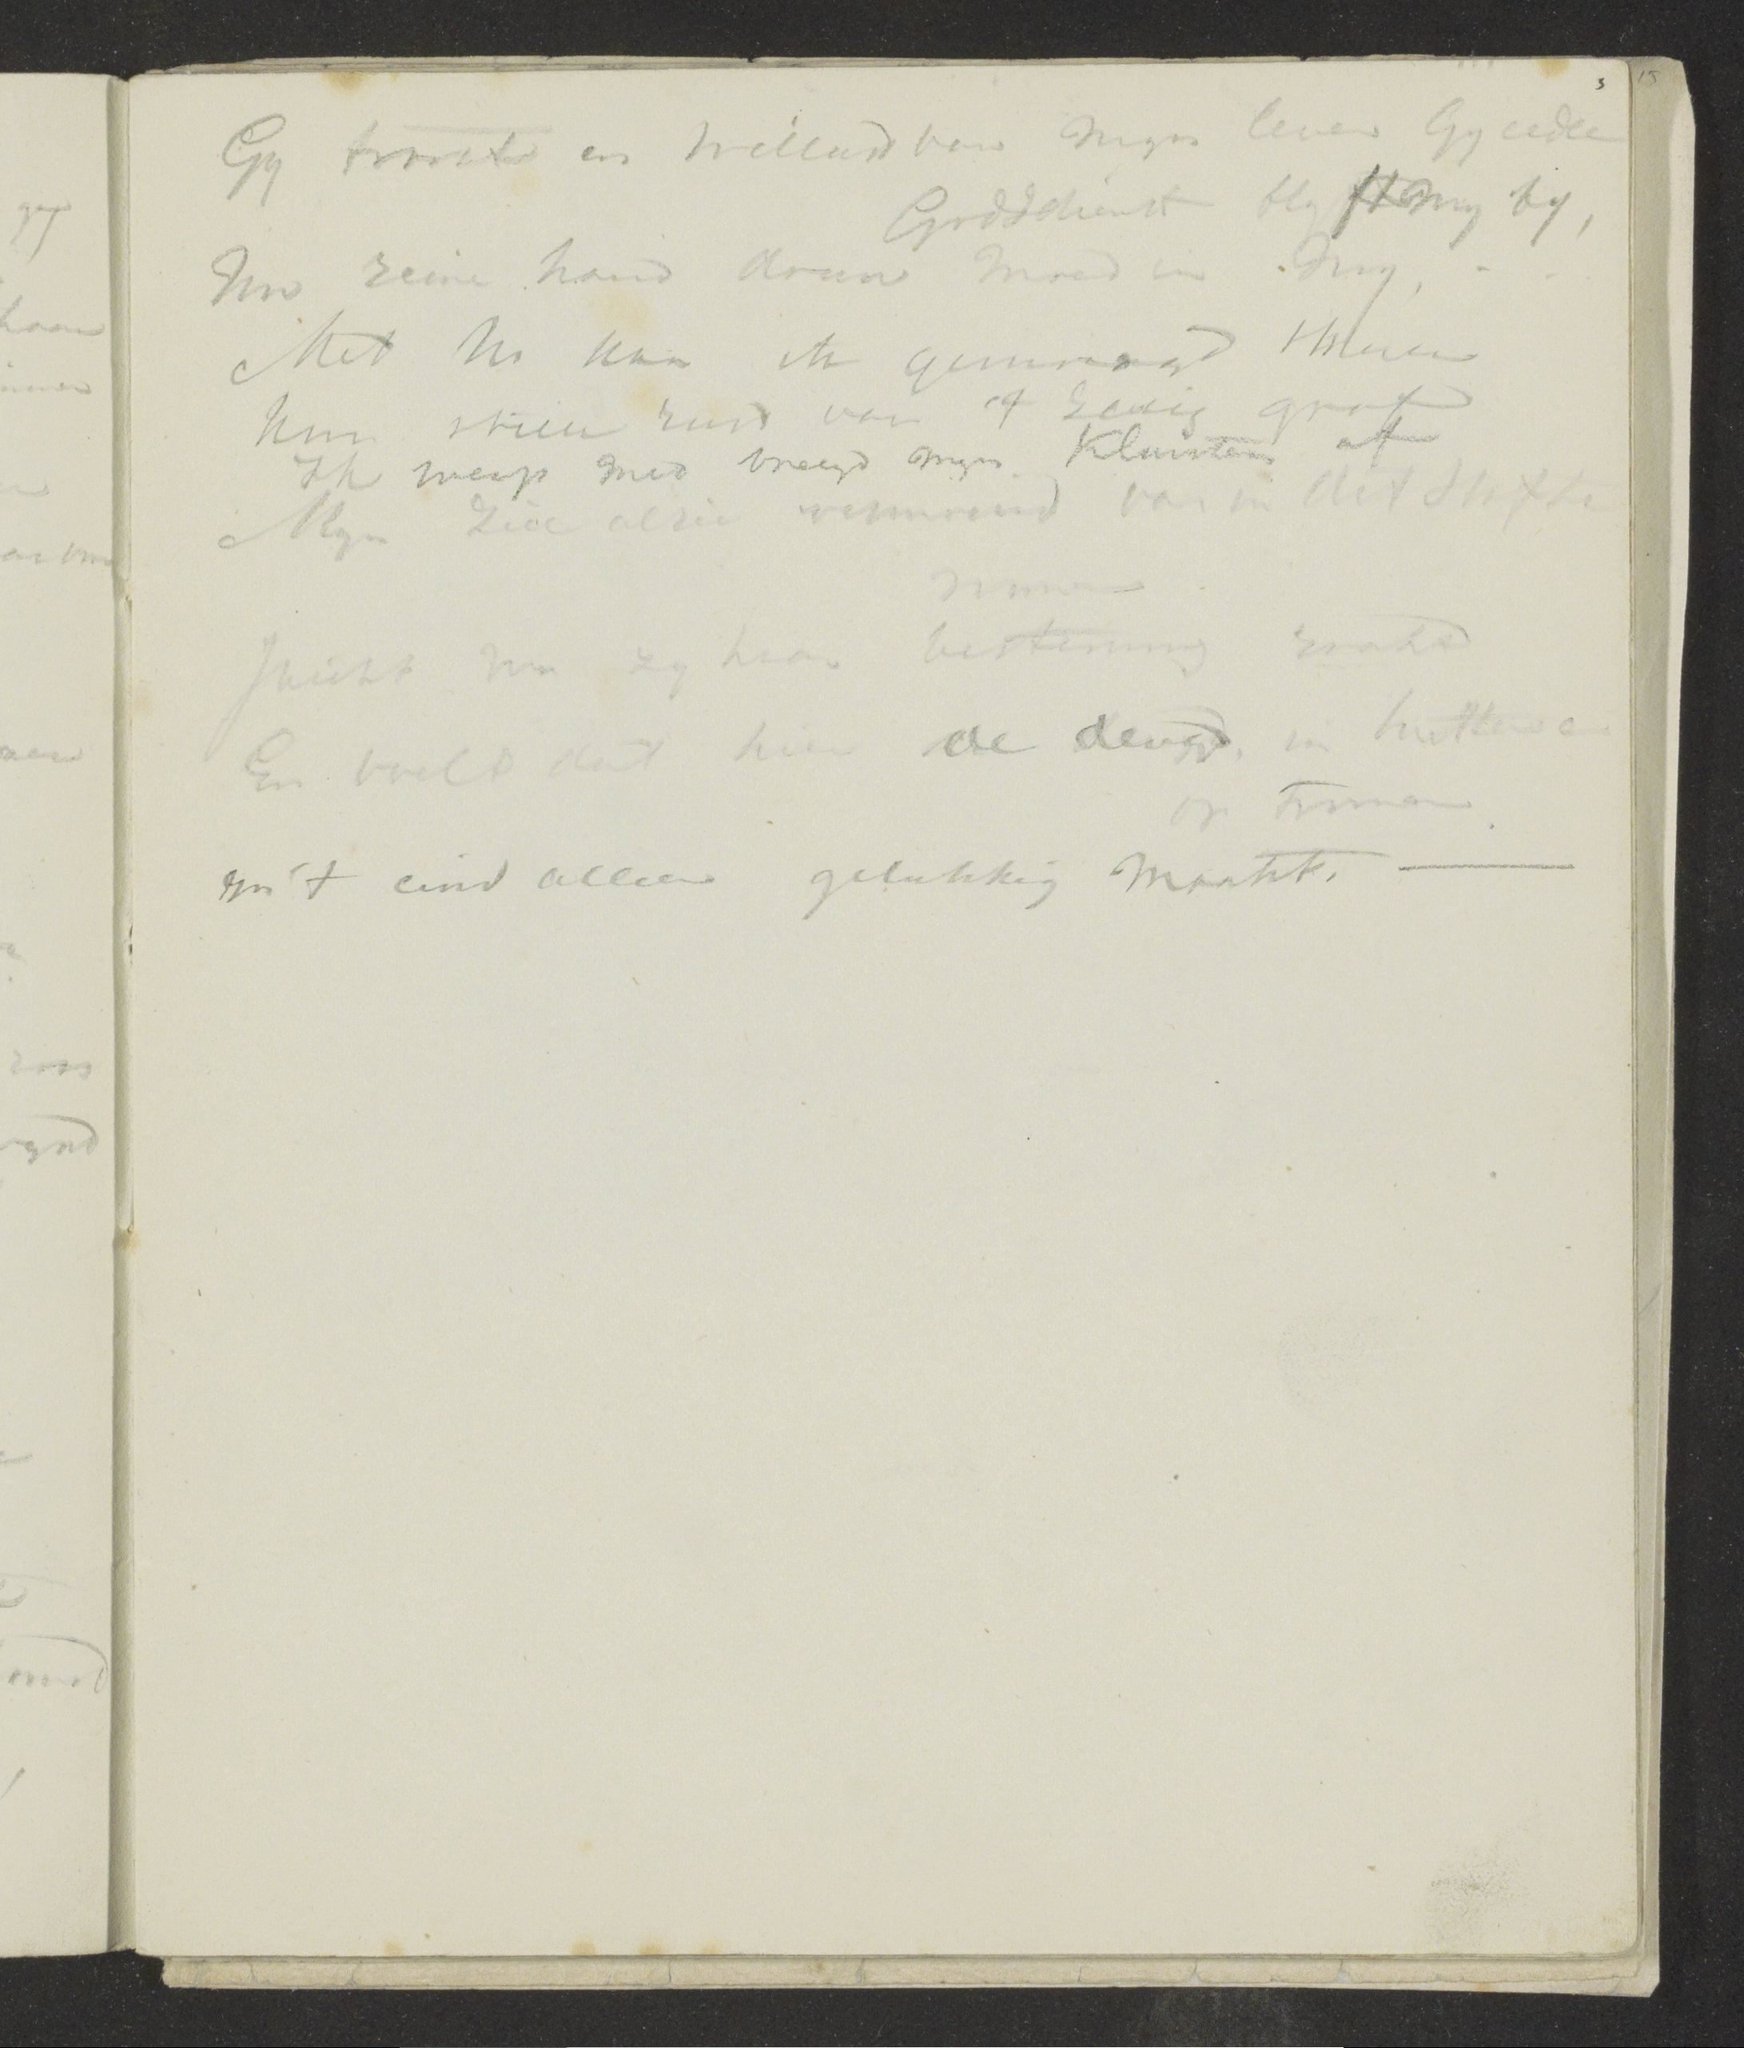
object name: sketchbook leaf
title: Gedicht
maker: maria vos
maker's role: draughtsman, painter, print maker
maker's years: 1824-1906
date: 1834-1906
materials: paper, pencil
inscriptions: annotation: ‘[...]’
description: Blad 3 recto uit een schetsboek met 17 bladen.